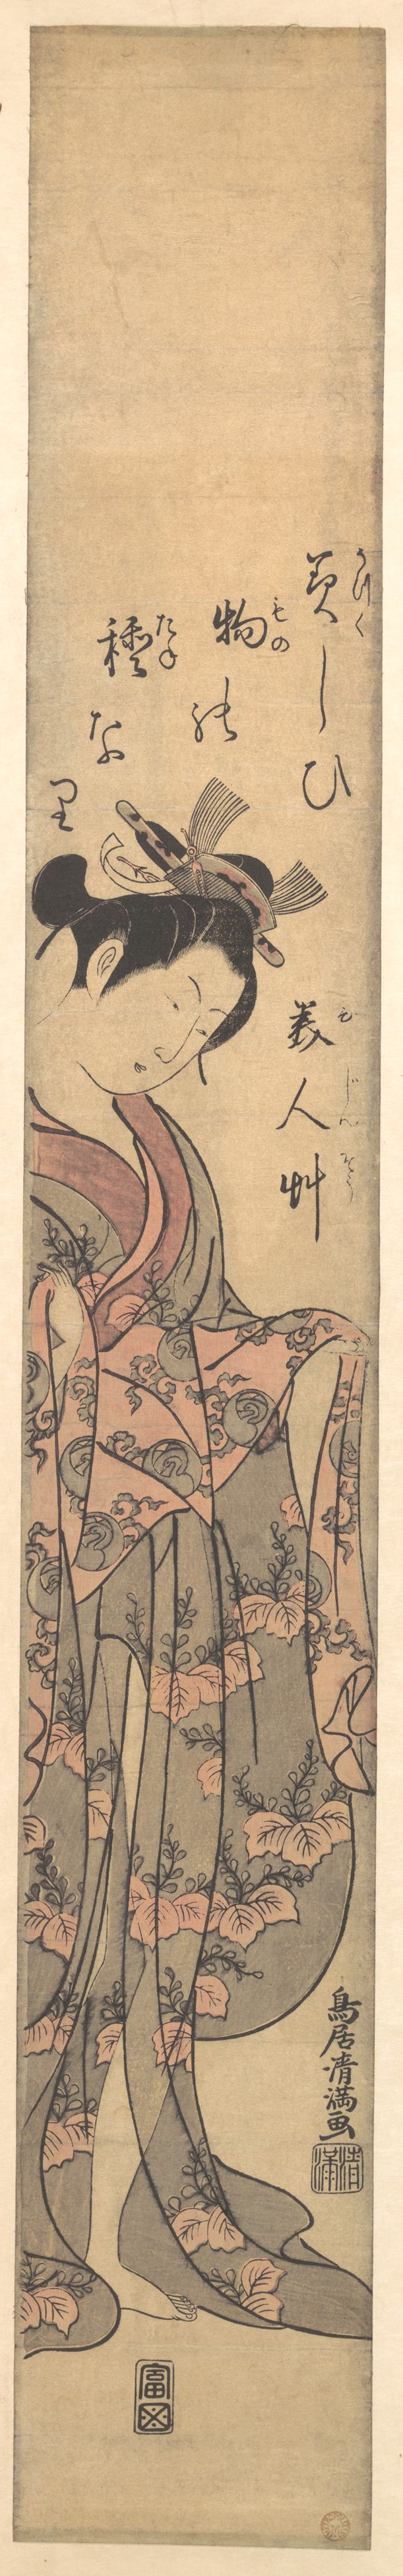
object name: print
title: The Actor Bando Hikosaburo 2nd as an Oiran in a Gauze Kimono, Standing, Tying Her Obi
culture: japanese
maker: torii kiyomitsu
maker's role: artist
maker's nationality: japanese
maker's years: 1735-1785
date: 1764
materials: ink, paper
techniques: woodblock print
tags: women,actors